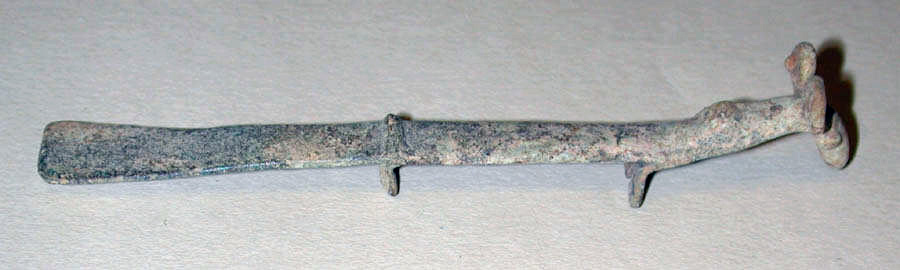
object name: spatula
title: Lime Spatula with Animal Head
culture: indonesian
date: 500 BCE-300 CE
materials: bronze